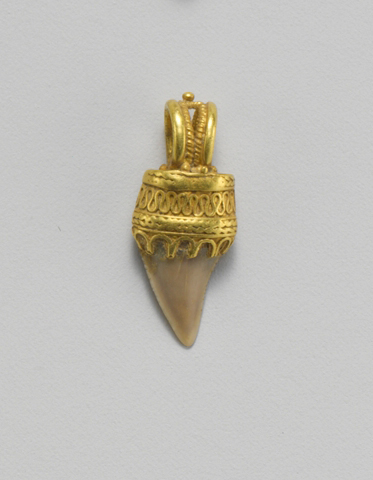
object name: pendant with tooth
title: Tooth pendant set in gold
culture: etruscan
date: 400-301 BCE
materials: bone, gold